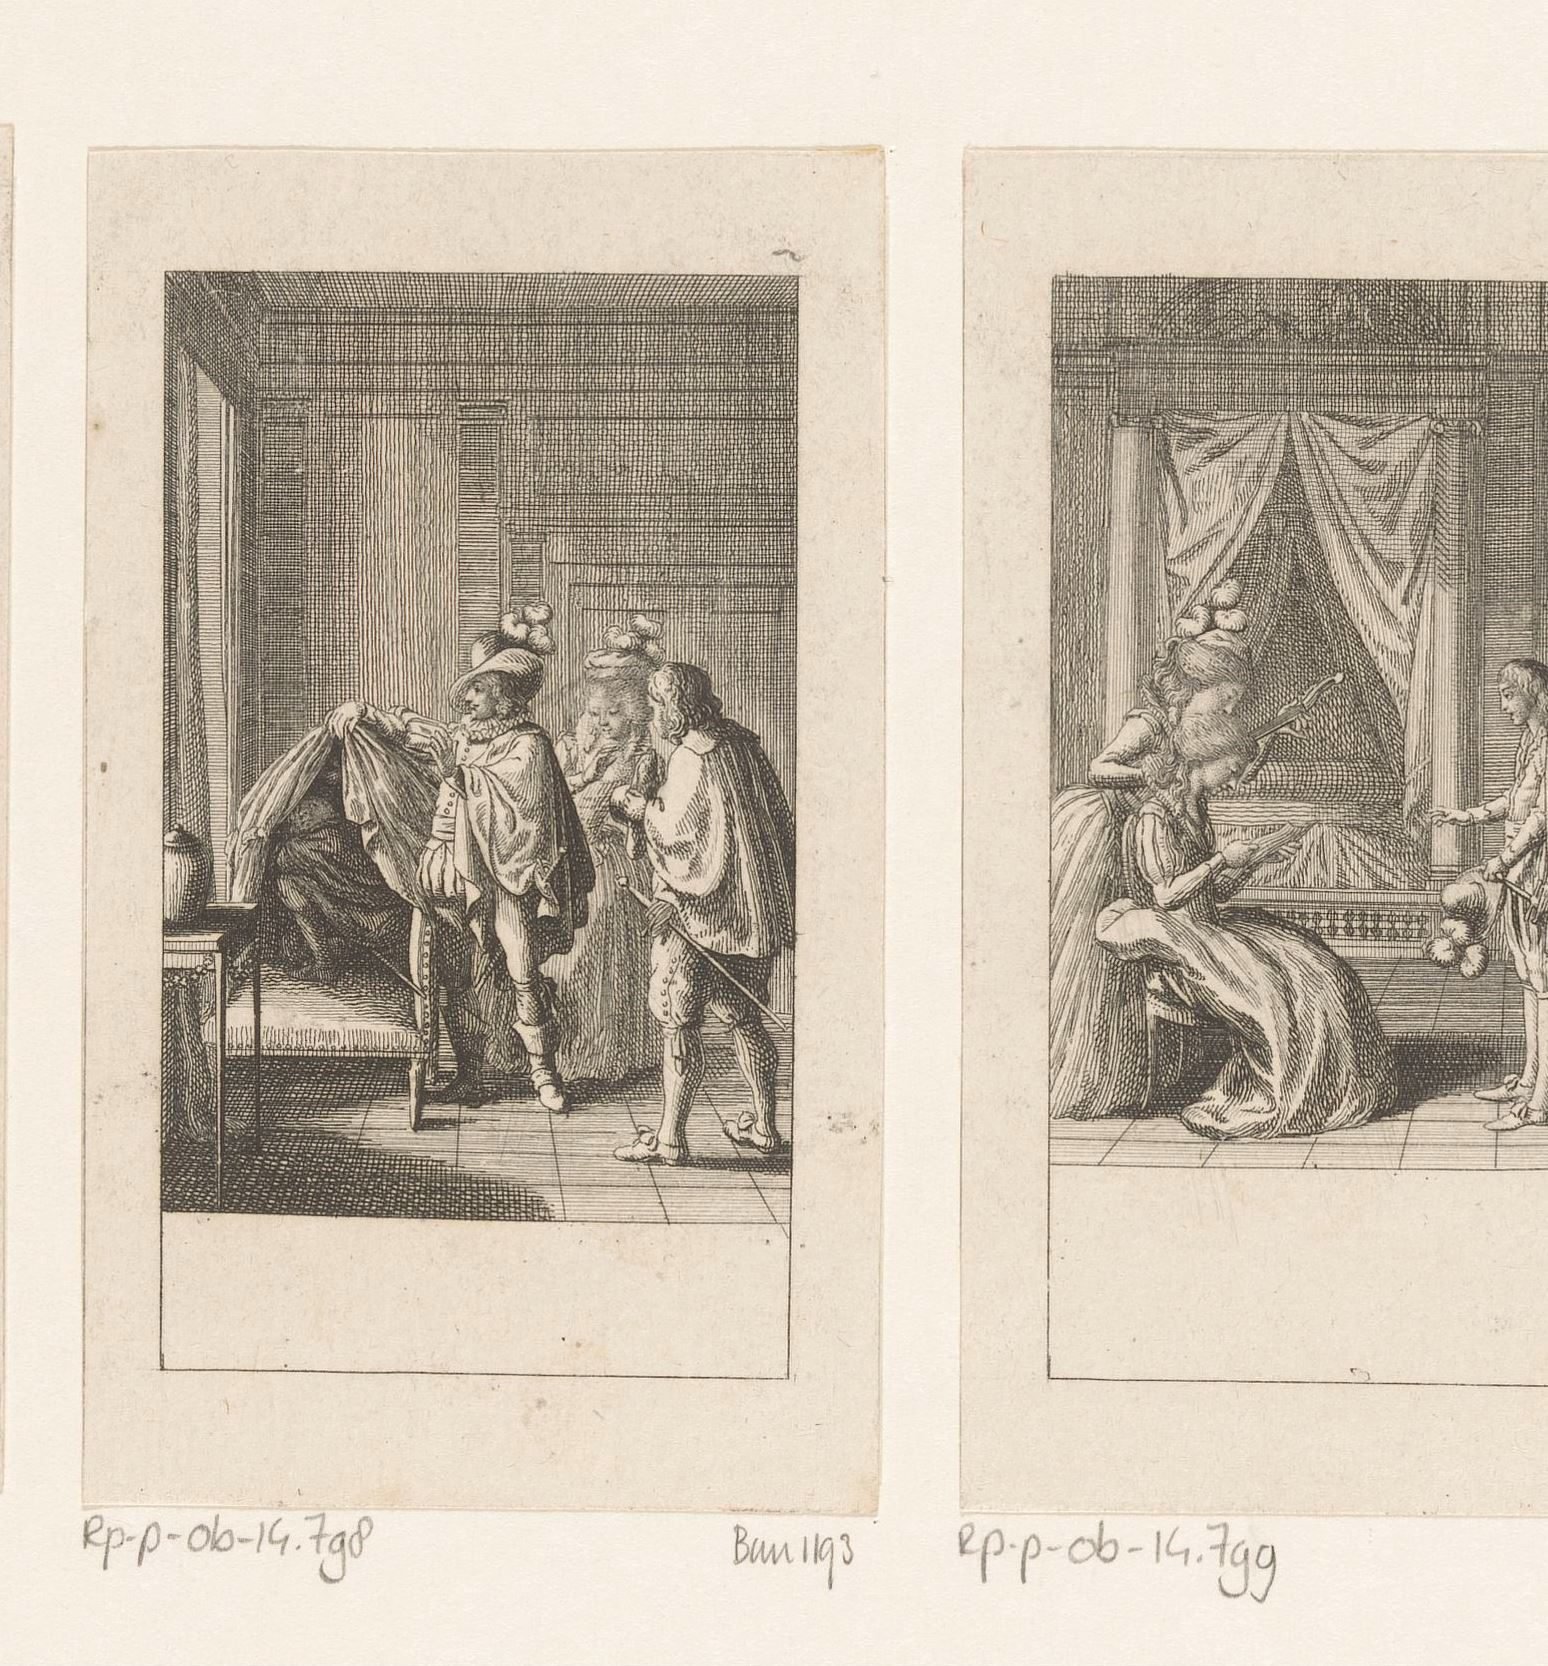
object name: print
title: Graaf Almavira ontdekt Chérubim onder het kleed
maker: daniel nikolaus chodowiecki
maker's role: draughtsman, print maker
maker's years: 1726-1801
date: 1785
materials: paper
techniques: etching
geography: berlin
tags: paris, publisher, literature, hiding, hiding oneself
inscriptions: collector's mark: Lugt 2228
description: Vervaardigd voor 'le Mariage de Figaro' van Pierre Augustin Caron de Beaumarchais. Latere staat gebruikt voor: Almanac de Gotha contenant diverses connoissances curieuses et utiles pour l'année (...). Gotha: C. W. Ettinger, 1785.